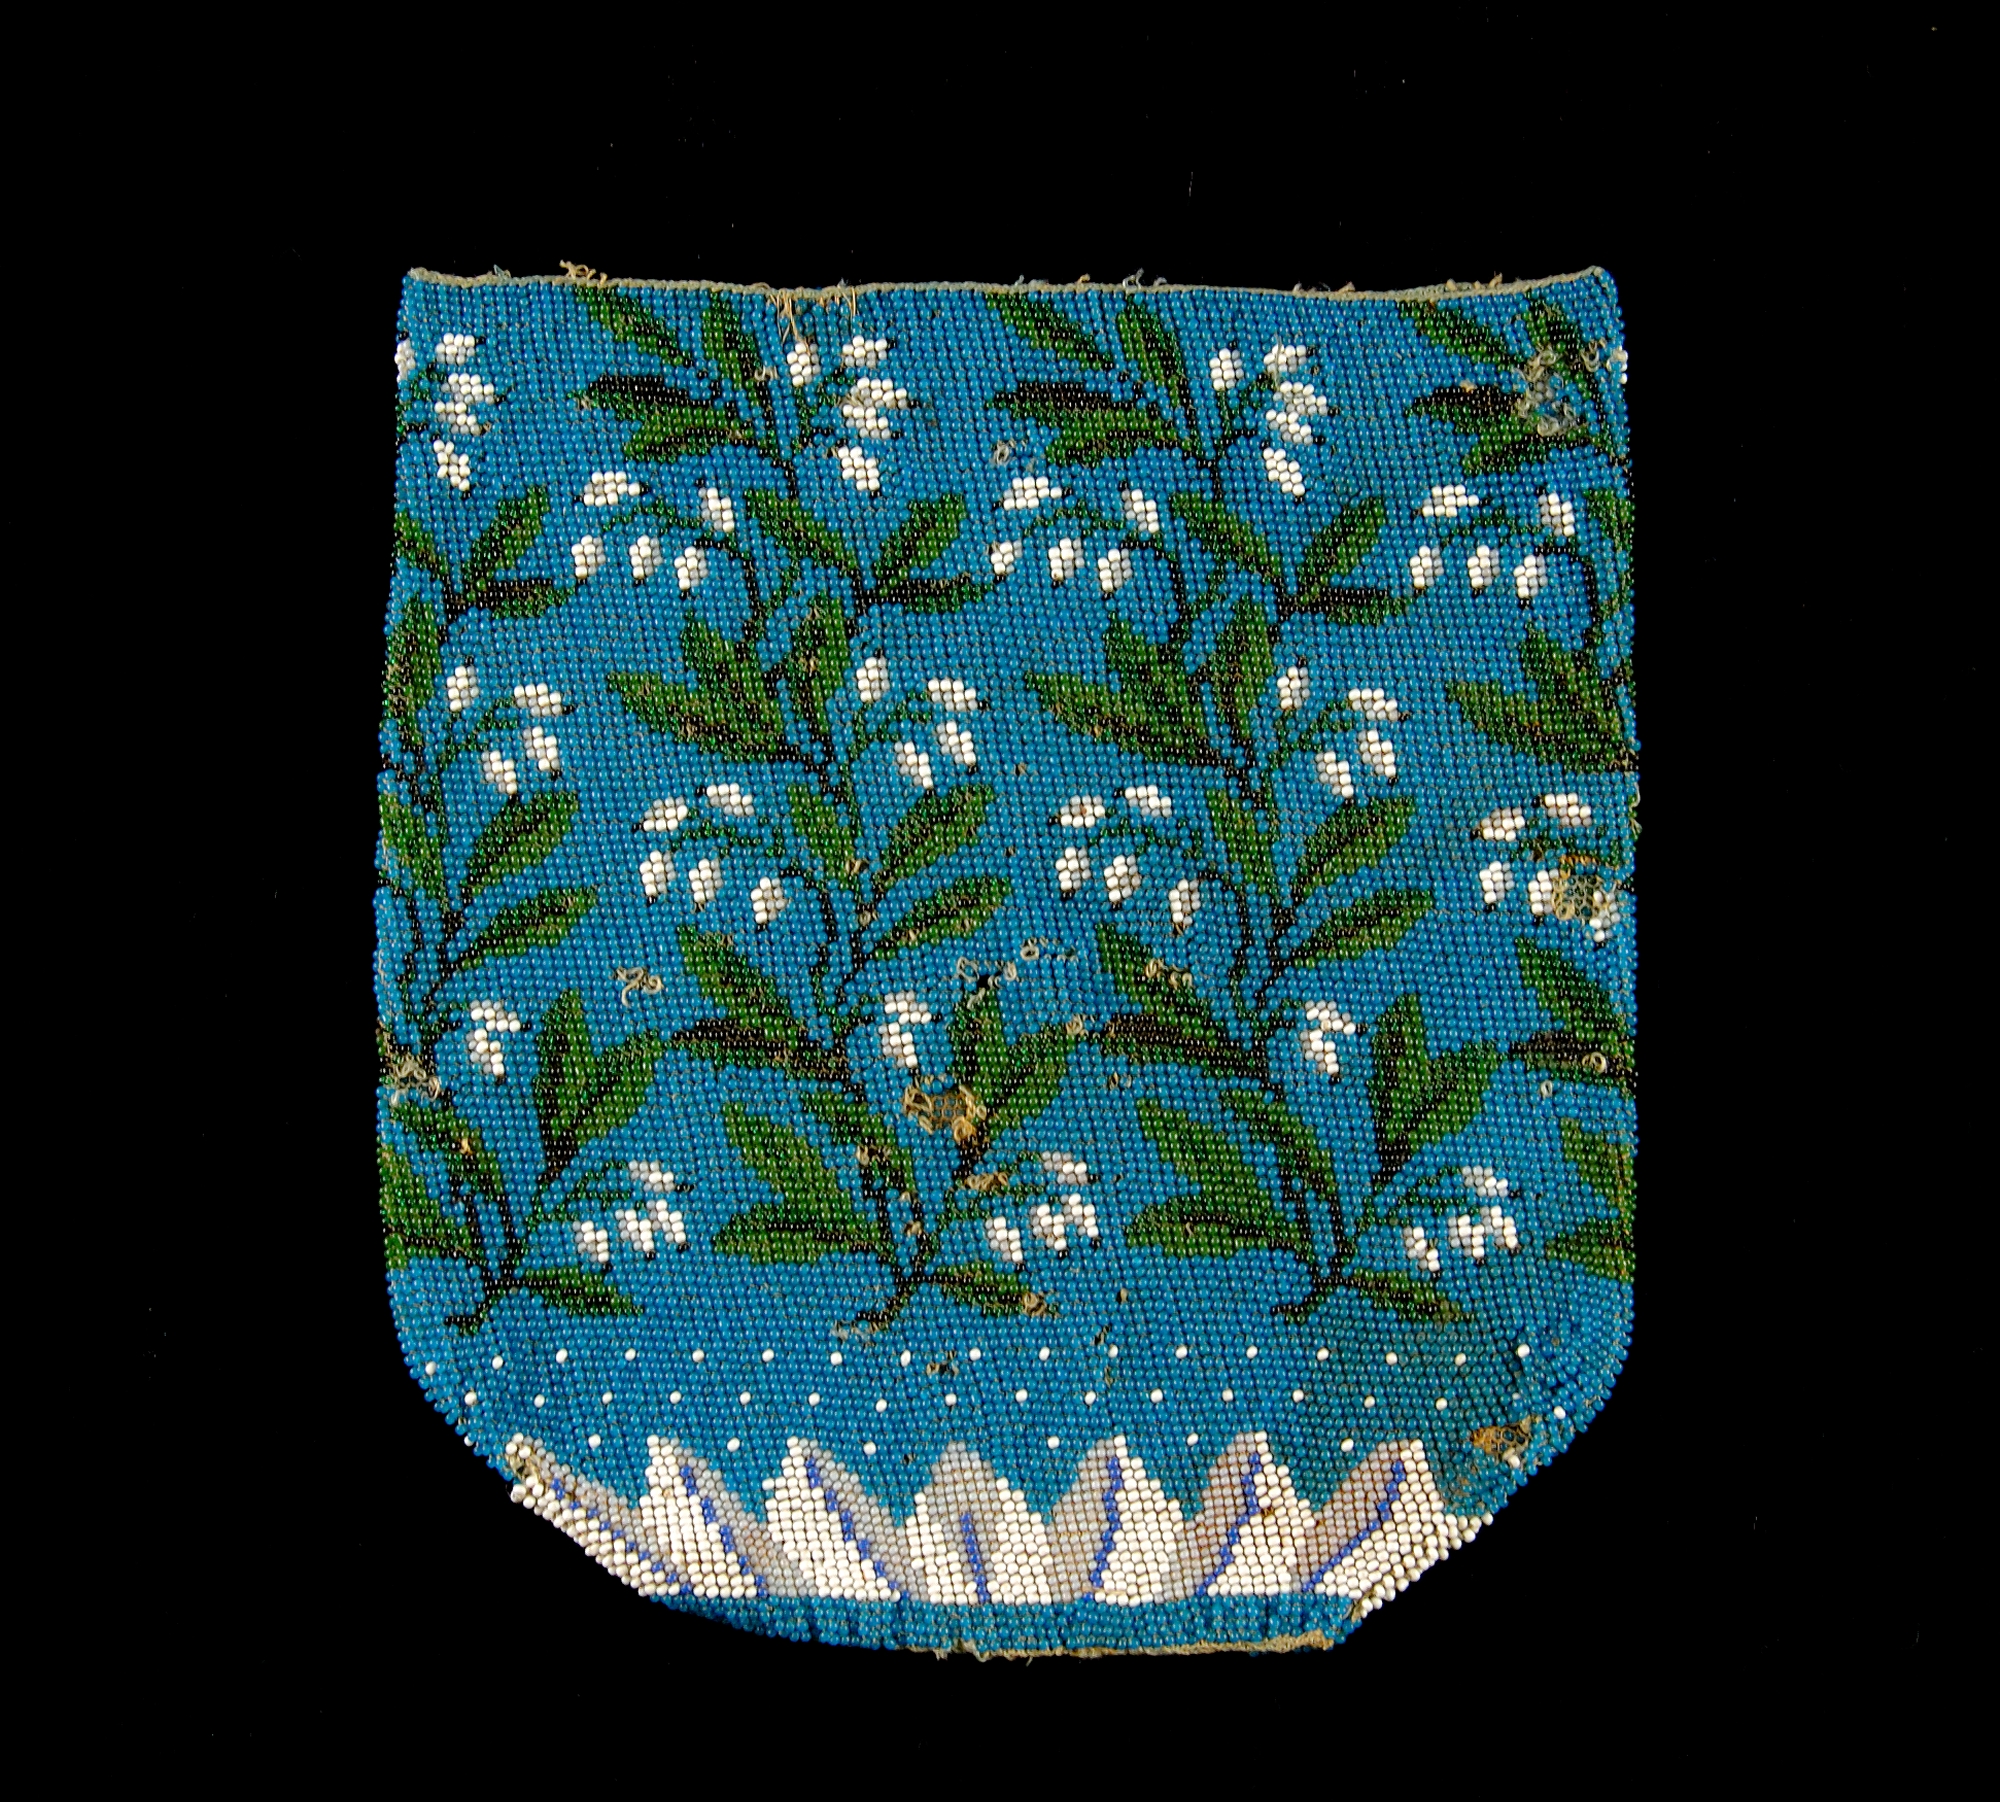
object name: pouch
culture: american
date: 1830-1860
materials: glass, linen